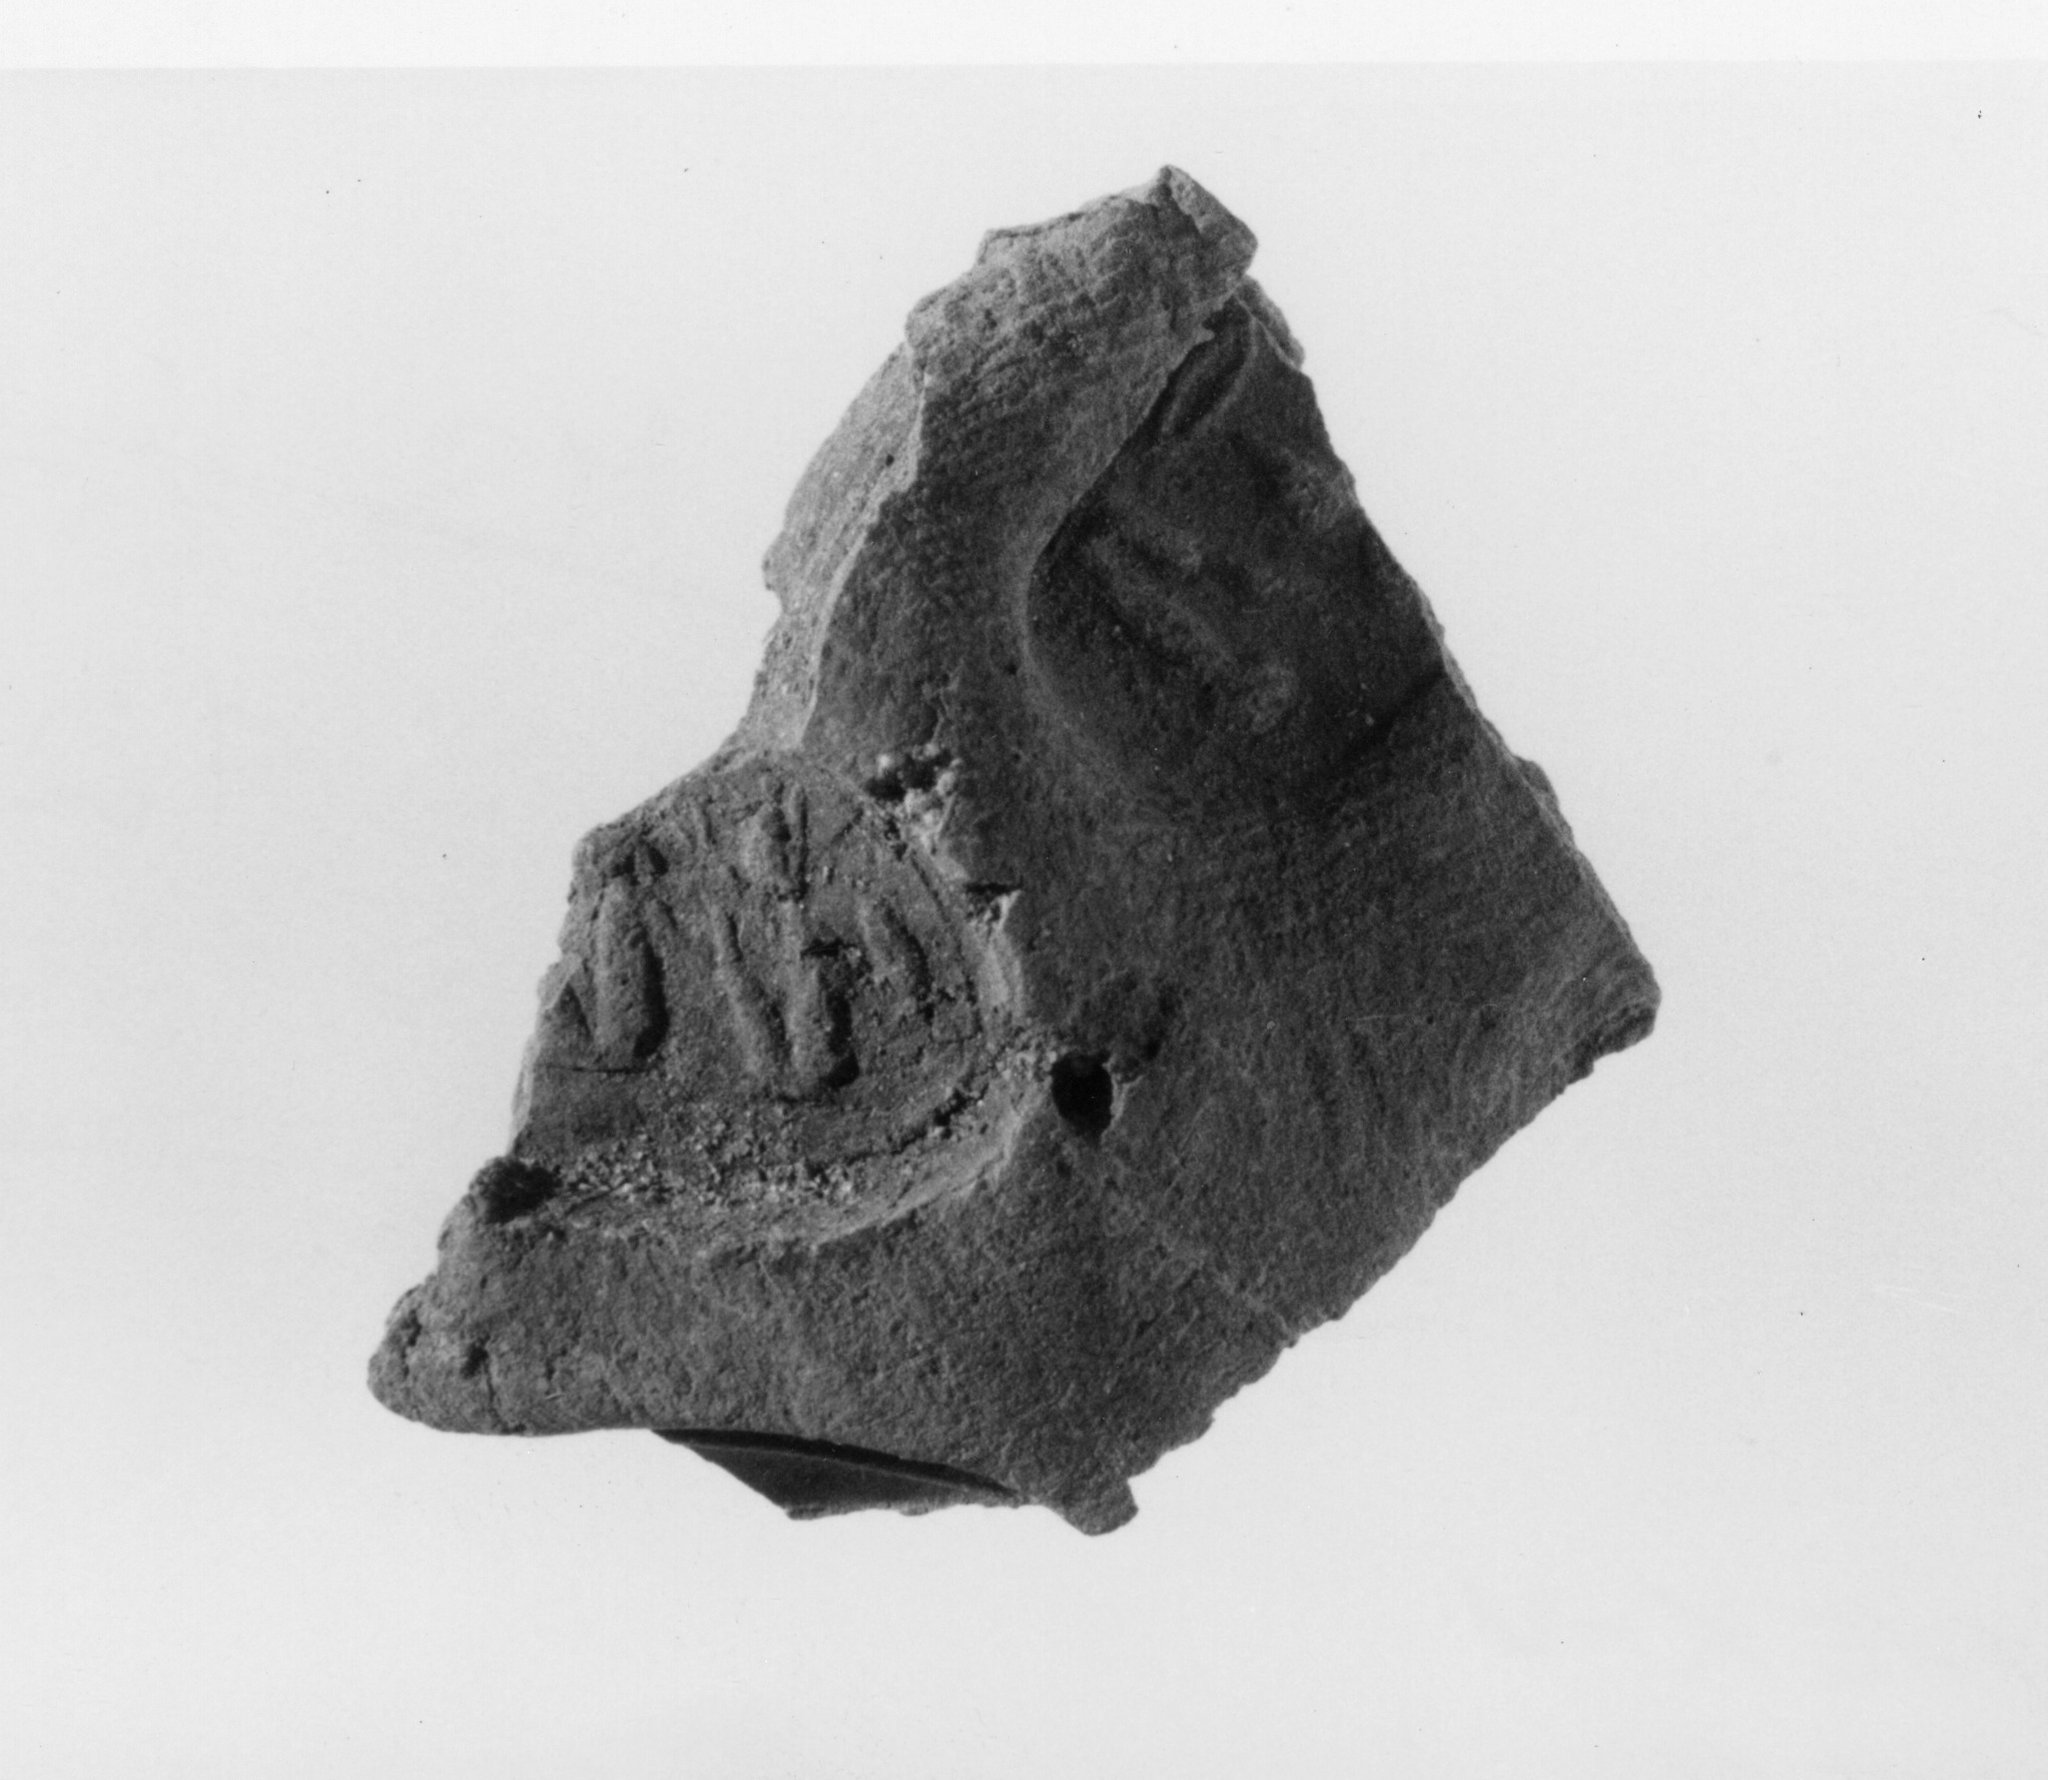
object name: sealing, nebmaatre, amenhotep iii,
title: Document Sealing With Multiple Seal Impressions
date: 1390-1352 BCE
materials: mud